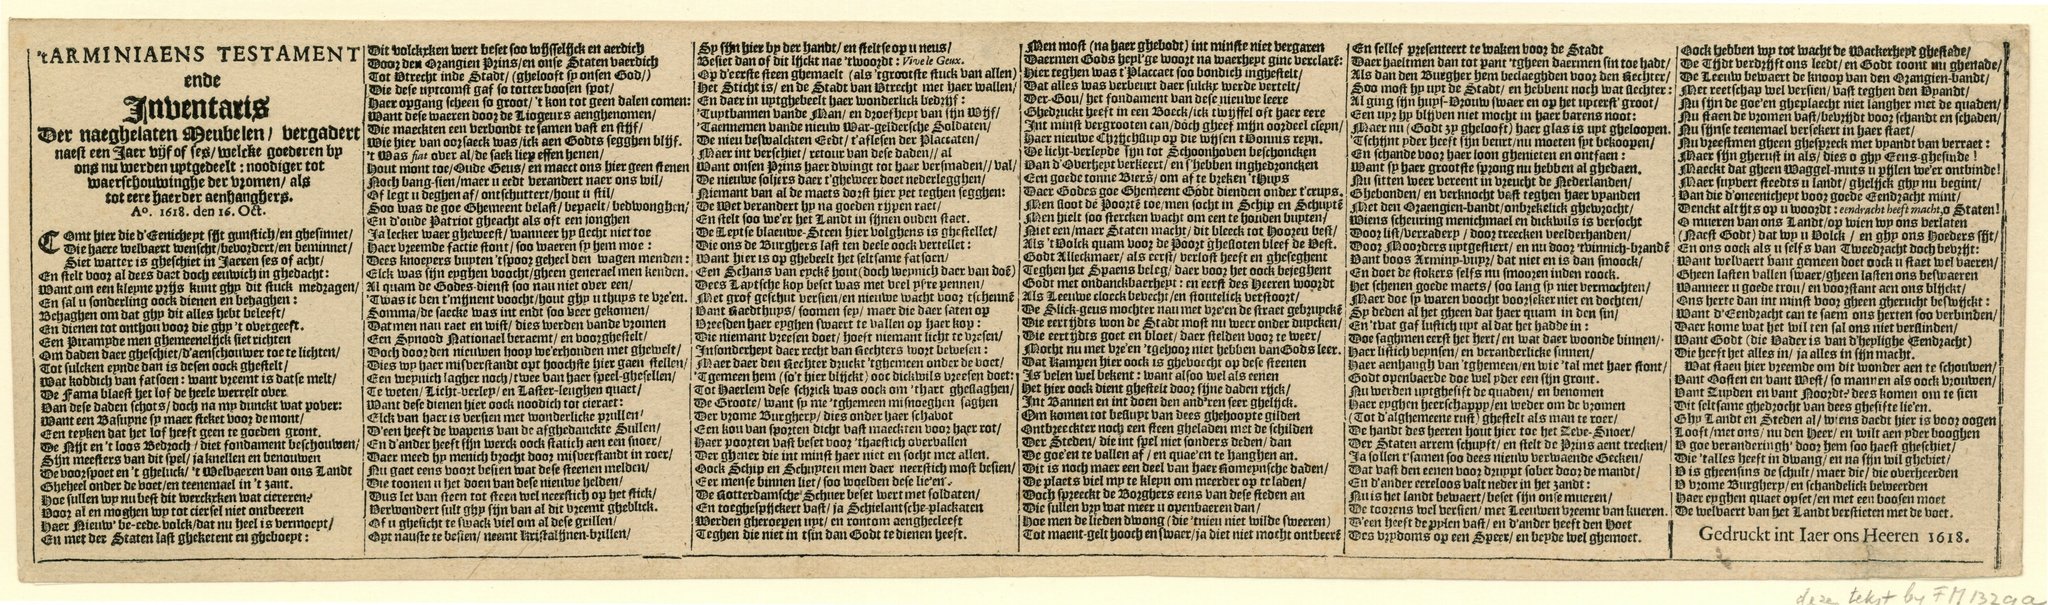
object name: text sheet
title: Tekstblad behorend bij Het Arminiaans Testament, 1618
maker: claes jansz. visscher (ii)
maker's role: draughtsman, print maker, publisher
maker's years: 1586-1652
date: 1618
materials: paper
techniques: letterpress printing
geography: amsterdam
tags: breestraat, arminiaanse schans te leiden, remonstranten en contraremonstranten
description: Tekstblad behorend bij de prent 't Arminiaens Testament, de gedetailleerde allegorische voorstelling waarin de arminianen bespot worden, 1618. Zes kolommen tekst in het Nederlands.